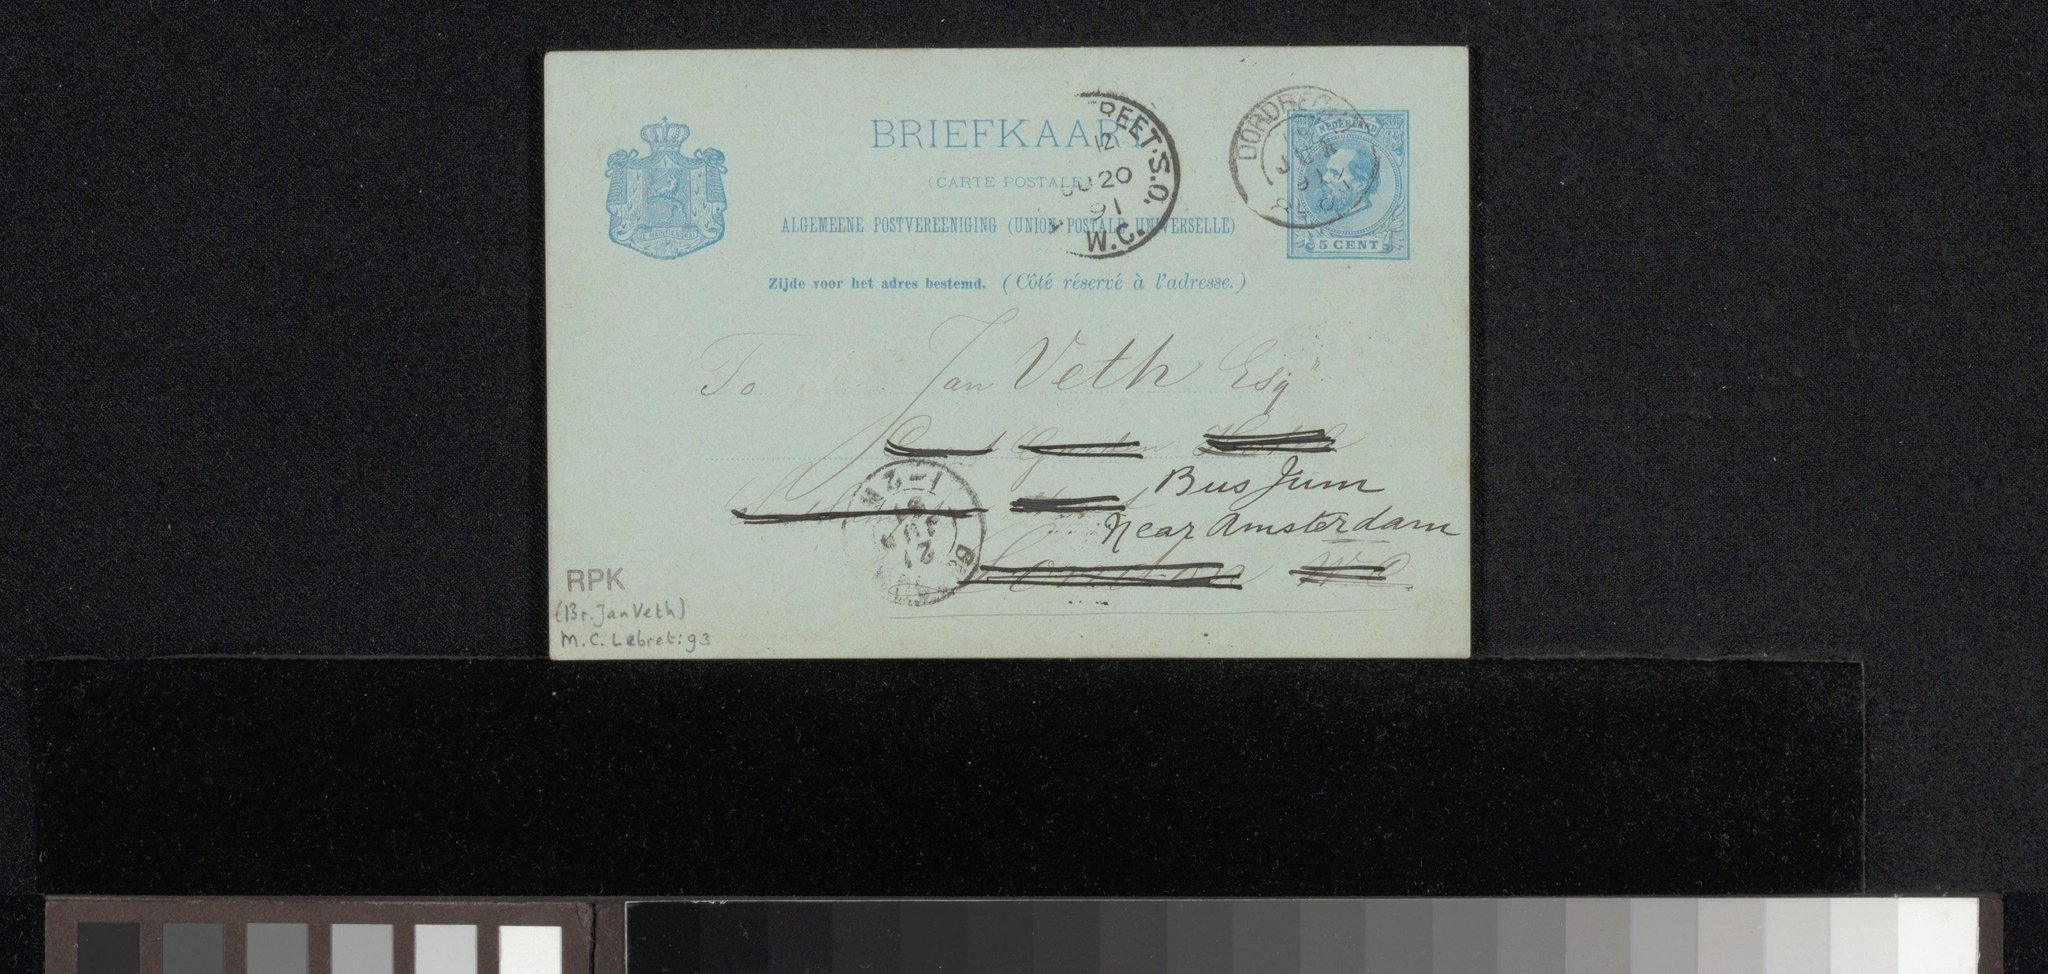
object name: postcard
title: Briefkaart aan Jan Veth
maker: martinus cornelis lebret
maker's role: verzamelaar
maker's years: 1833-1894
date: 1891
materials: cardboard, ink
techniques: pen, writing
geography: dordrecht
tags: amsterdam, painter, print maker, draughtsman, designer, jan veth, rotterdam, art collecting, london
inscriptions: collector's mark: ‘RPK’